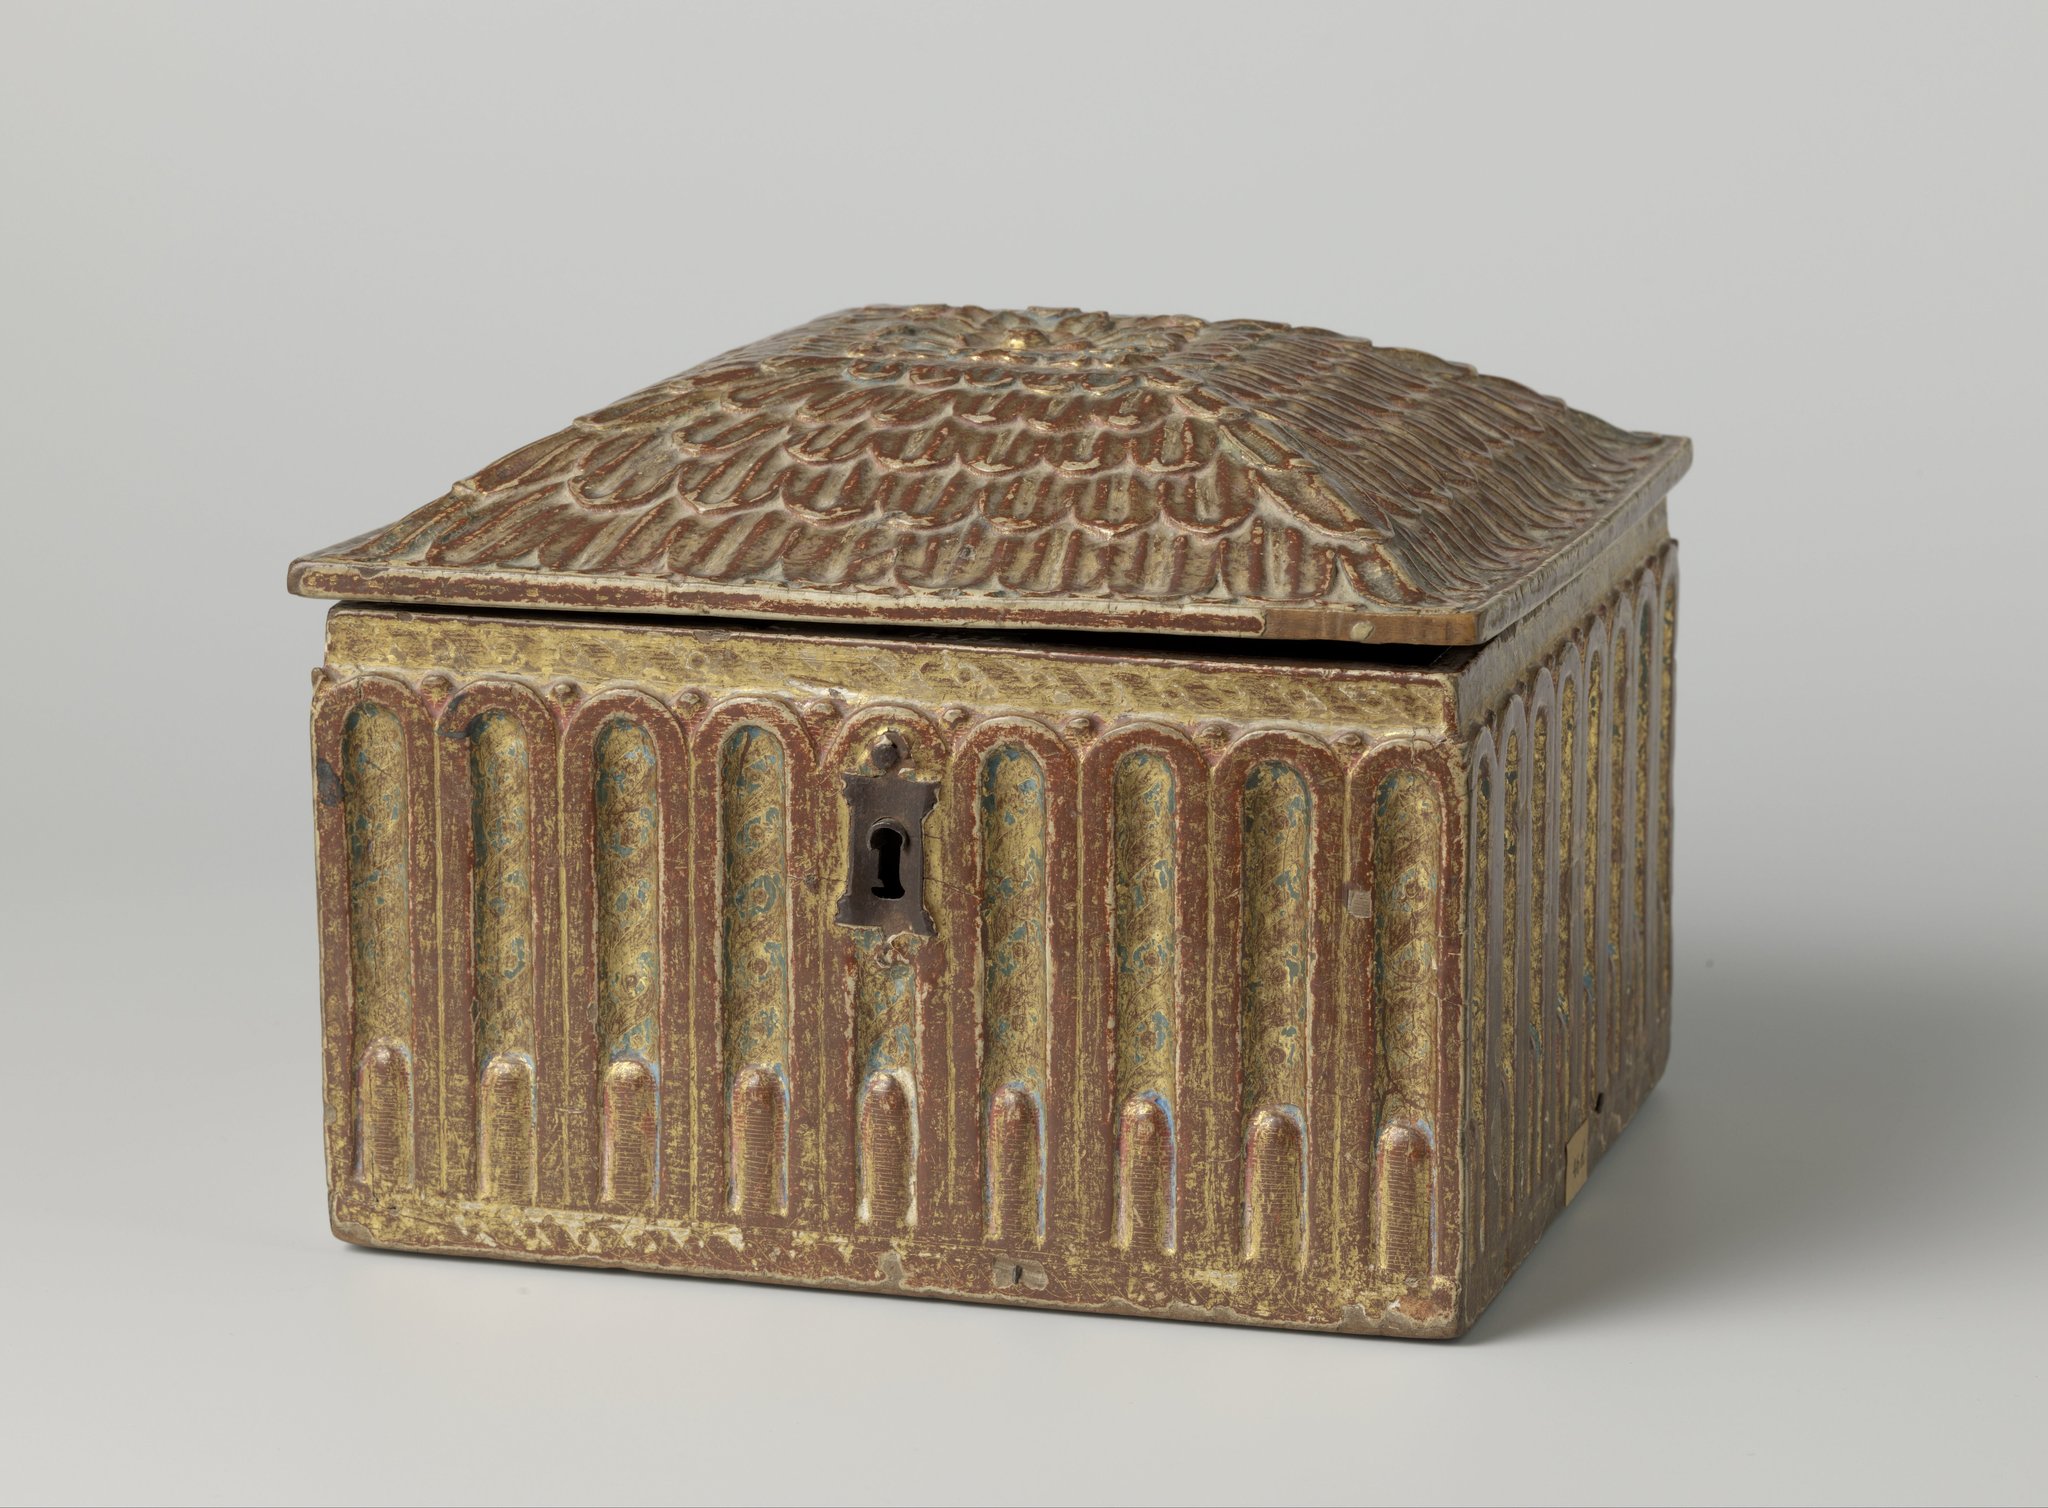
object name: chest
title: Kist met gewelfd deksel, versierd met cannelures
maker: Anonymous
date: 1400-1500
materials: chalk, paint, wood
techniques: gilding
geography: venice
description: Kist, vierkant, met gewelfd deksel en aan vier zijden versierd met cannelures die tot op eenderde hoogte gevuld zijn. Op het deksel snijwerk van over elkaar liggend bladwerk. Het geheel is op rode ondergrond verguld en op meerdere plaatsen in blauw, rood en wit beschilderd. Van binnen is het kistje rood beschilderd, het deksel zwaar verguld met veelkleurige schildering met de letters IHS in lofwerk. De bodem is met vier haken aan de opstaande zijden bevestigd.